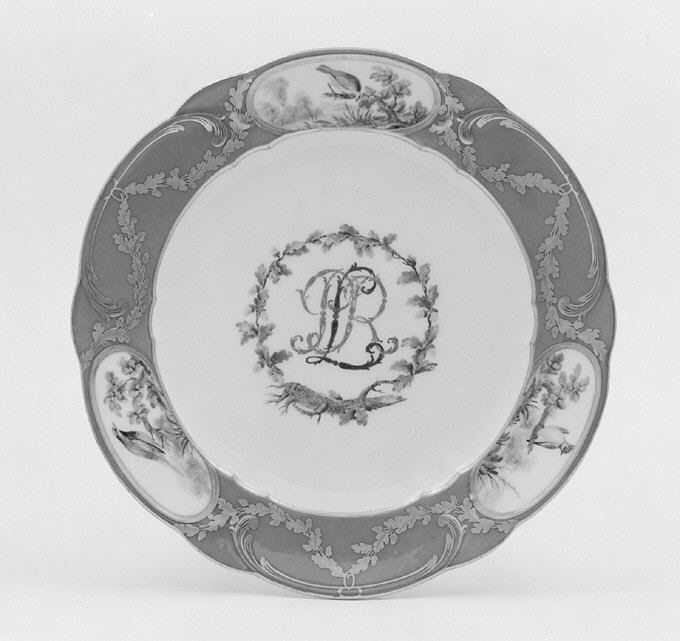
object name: plate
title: Plate (assiette à palmes) (one of four) (part of a service)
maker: sèvres manufactory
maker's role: manufactory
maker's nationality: french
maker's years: 1740-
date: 1771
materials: soft paste porcelain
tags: birds,wreaths,insignia